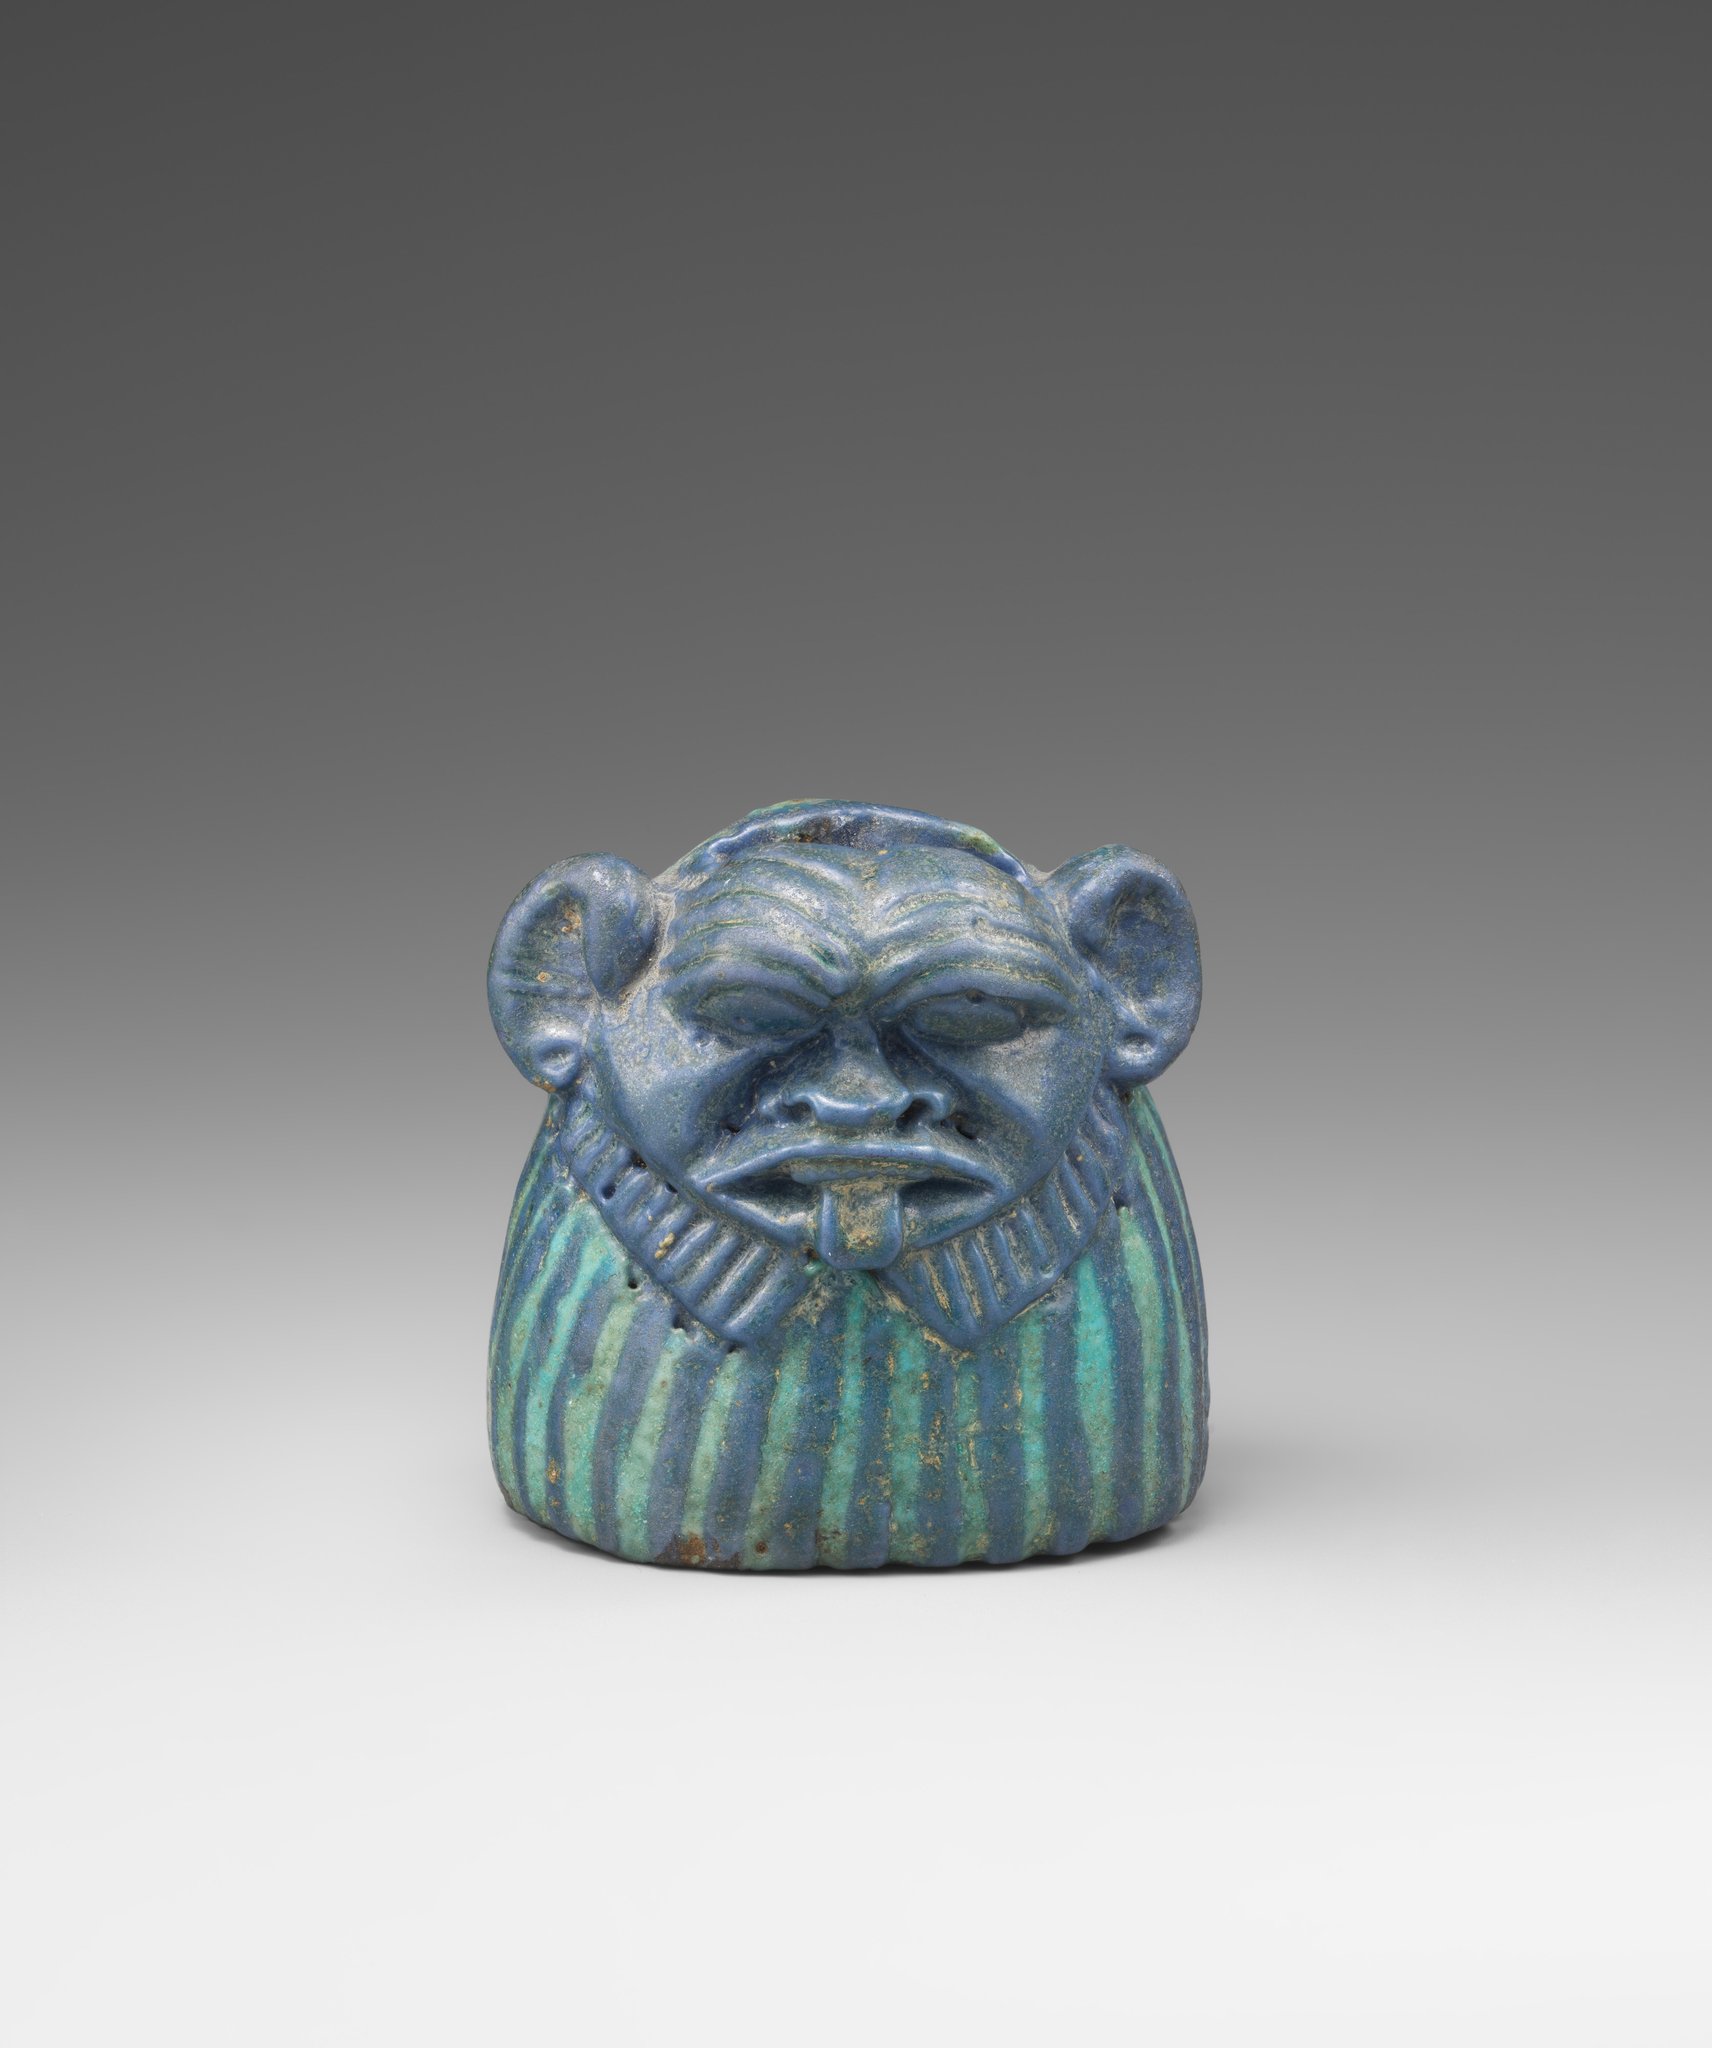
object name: mirror handle, be head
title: Bes-image as part of a mirror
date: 1390-1327 BCE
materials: faience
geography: egypt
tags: bes